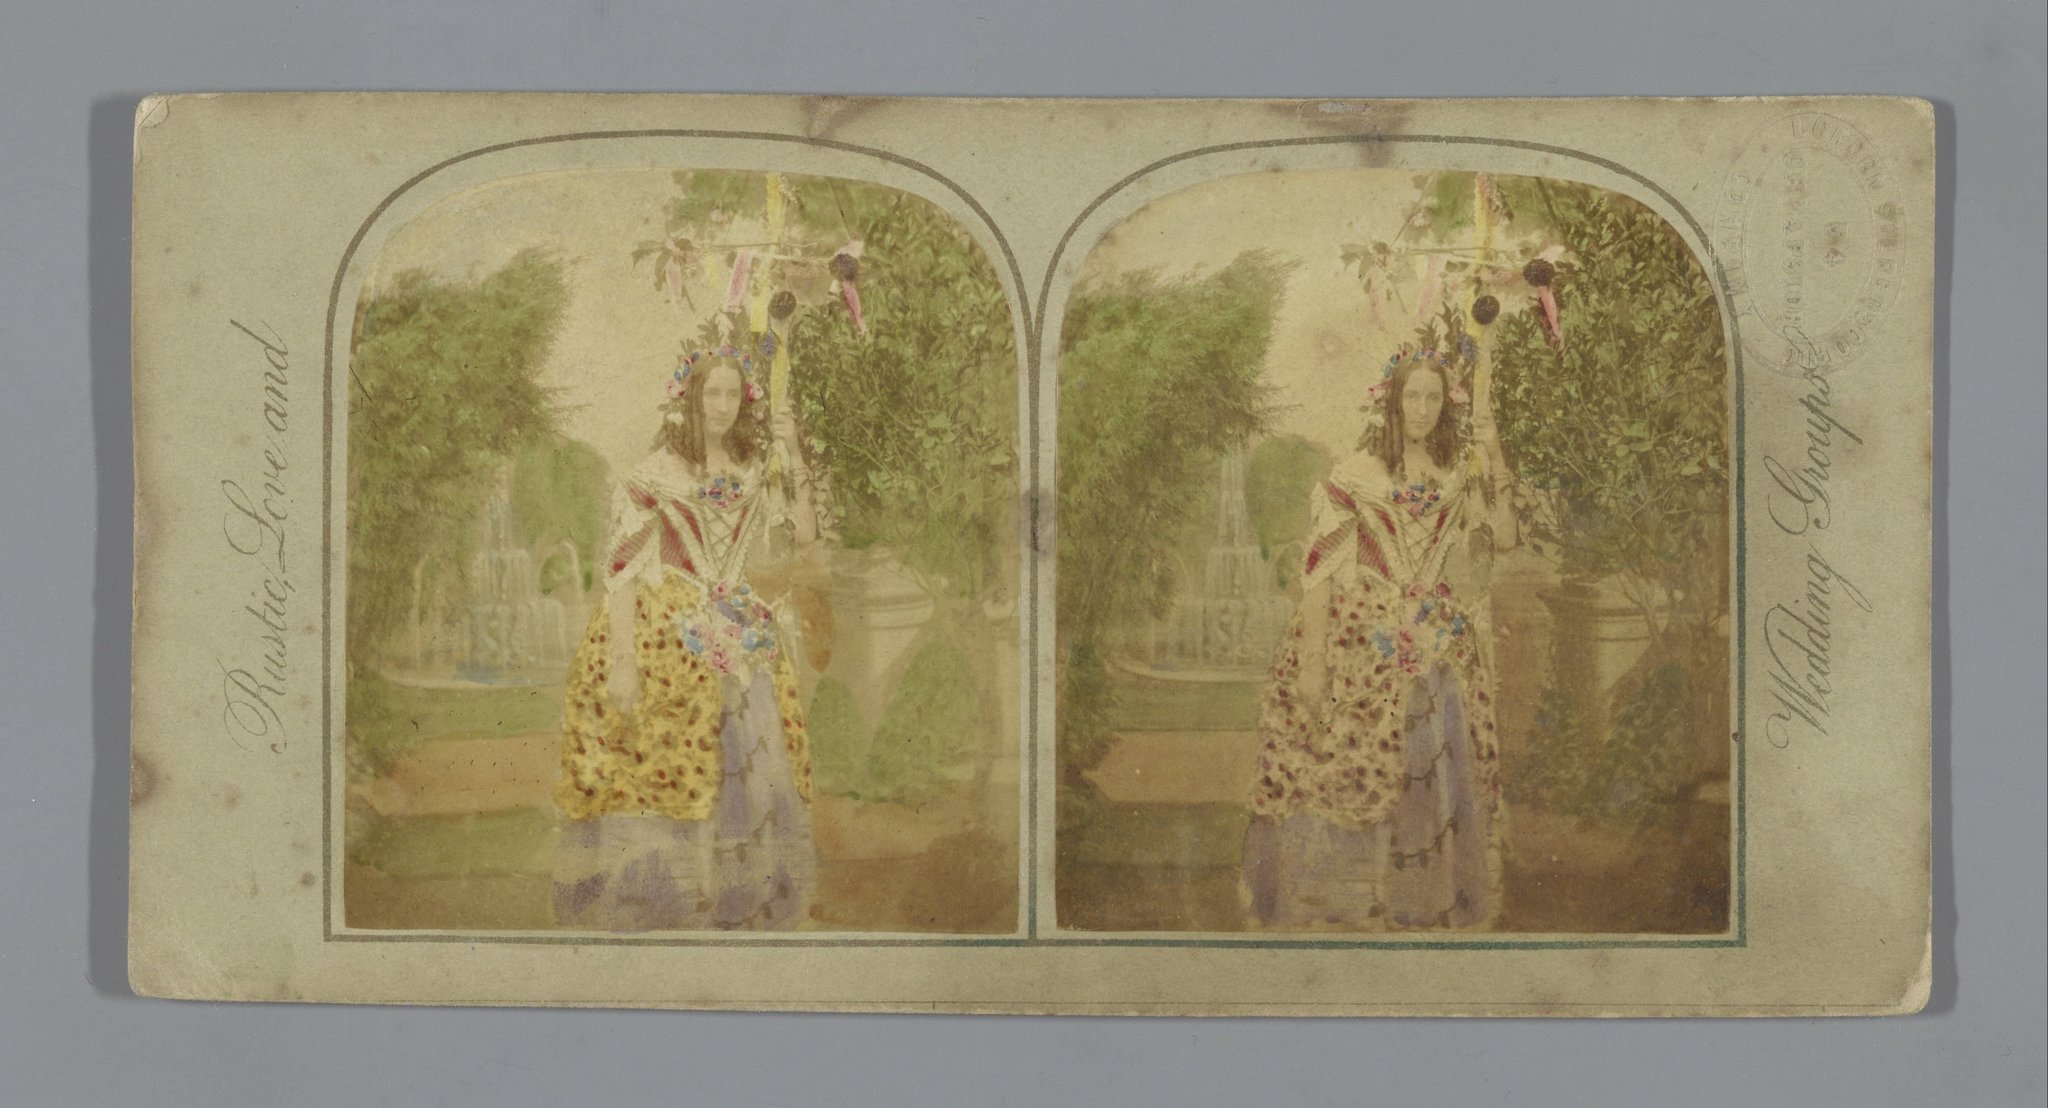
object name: stereograph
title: Rustic, Love and Wedding Groups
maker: Anonymous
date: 1854-1859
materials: cardboard, paper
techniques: albumen print, hand coloring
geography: london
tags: altarcross, crucifix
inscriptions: inscription: ‘No 20’, inscription: ‘The Hay Queen’